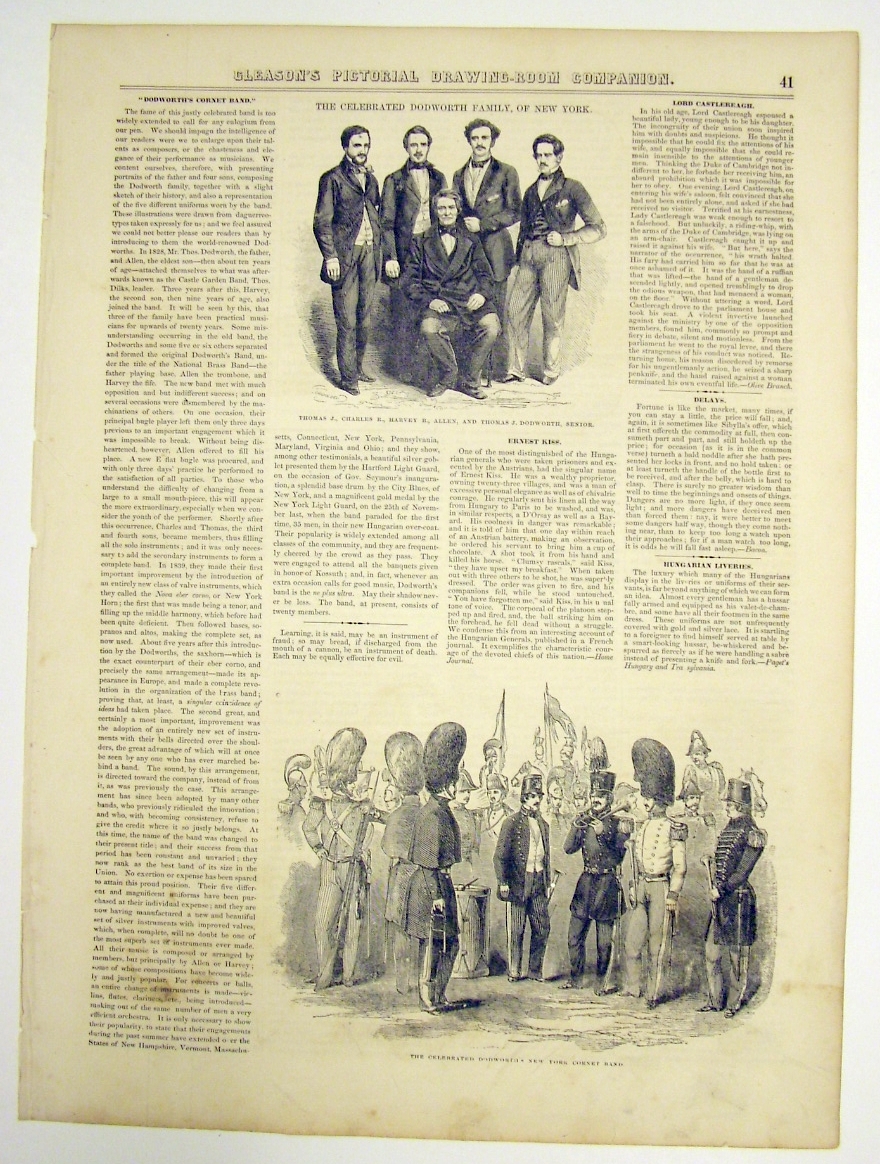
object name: newspaper illustration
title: The Celebrated Dodworth Family of New York newspaper illustration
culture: american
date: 1850-1859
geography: united states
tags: men,musicians